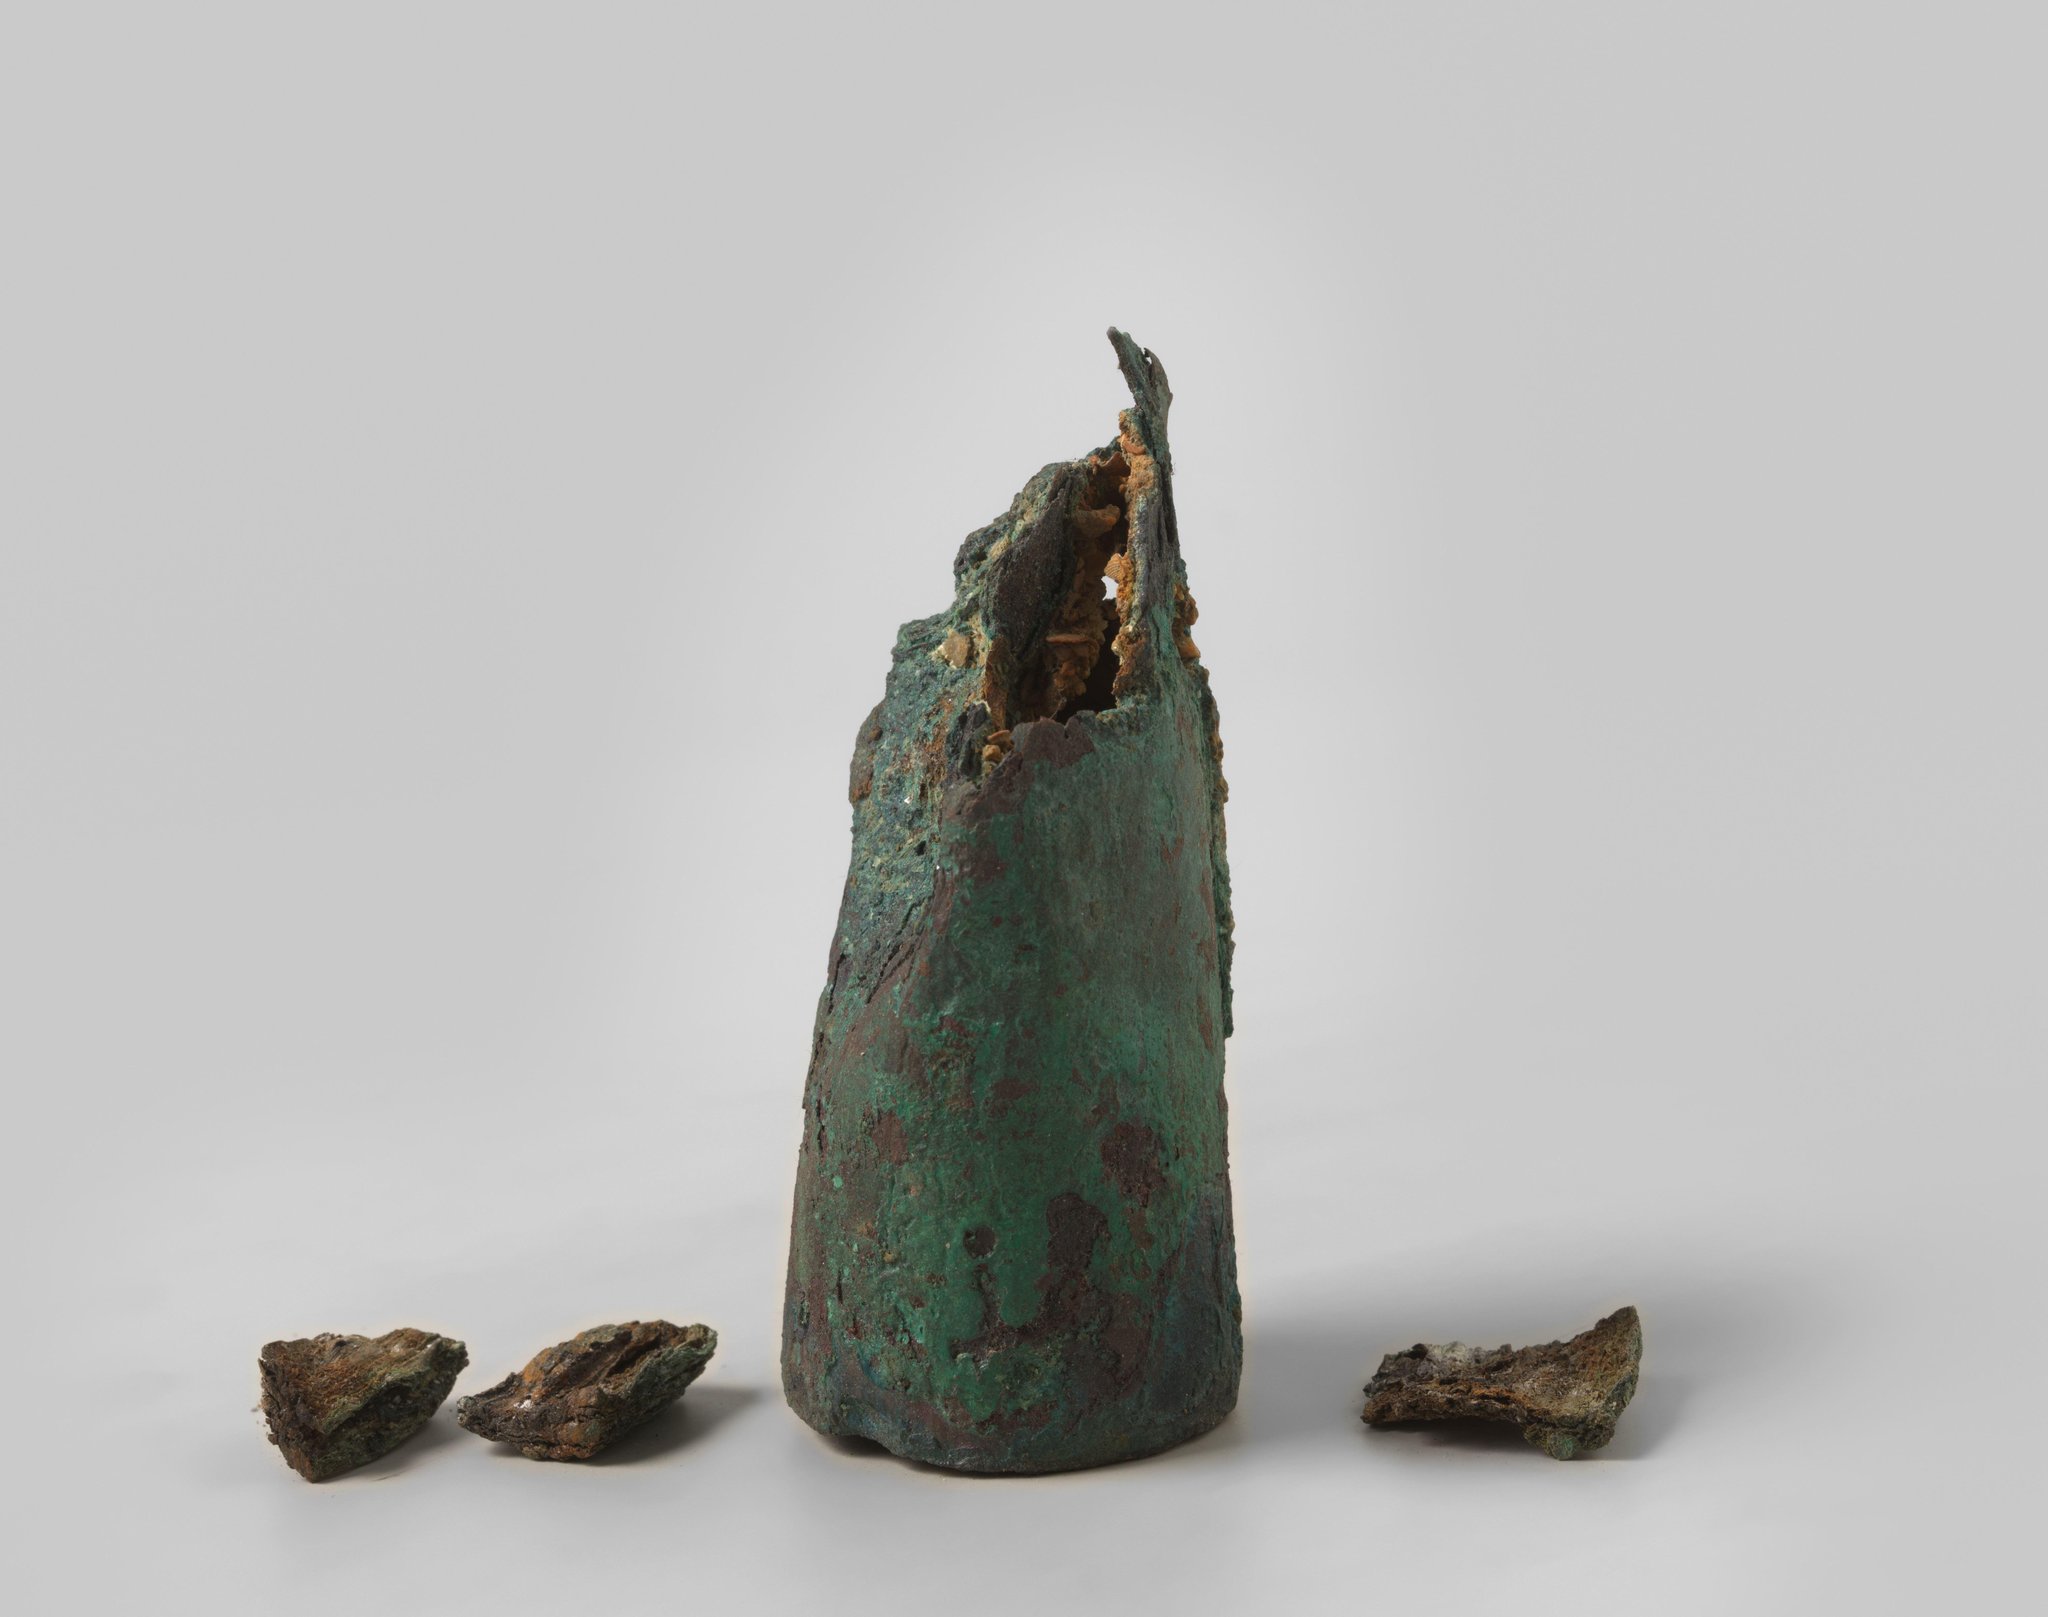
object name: rammer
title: Laadstok met houtfragmenten uit het wrak van de Oost-Indiëvaarder Hollandia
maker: Anonymous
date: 1700-1743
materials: copper, wood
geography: netherlands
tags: verenigde oostindische compagnie, hollandia (schip), annet